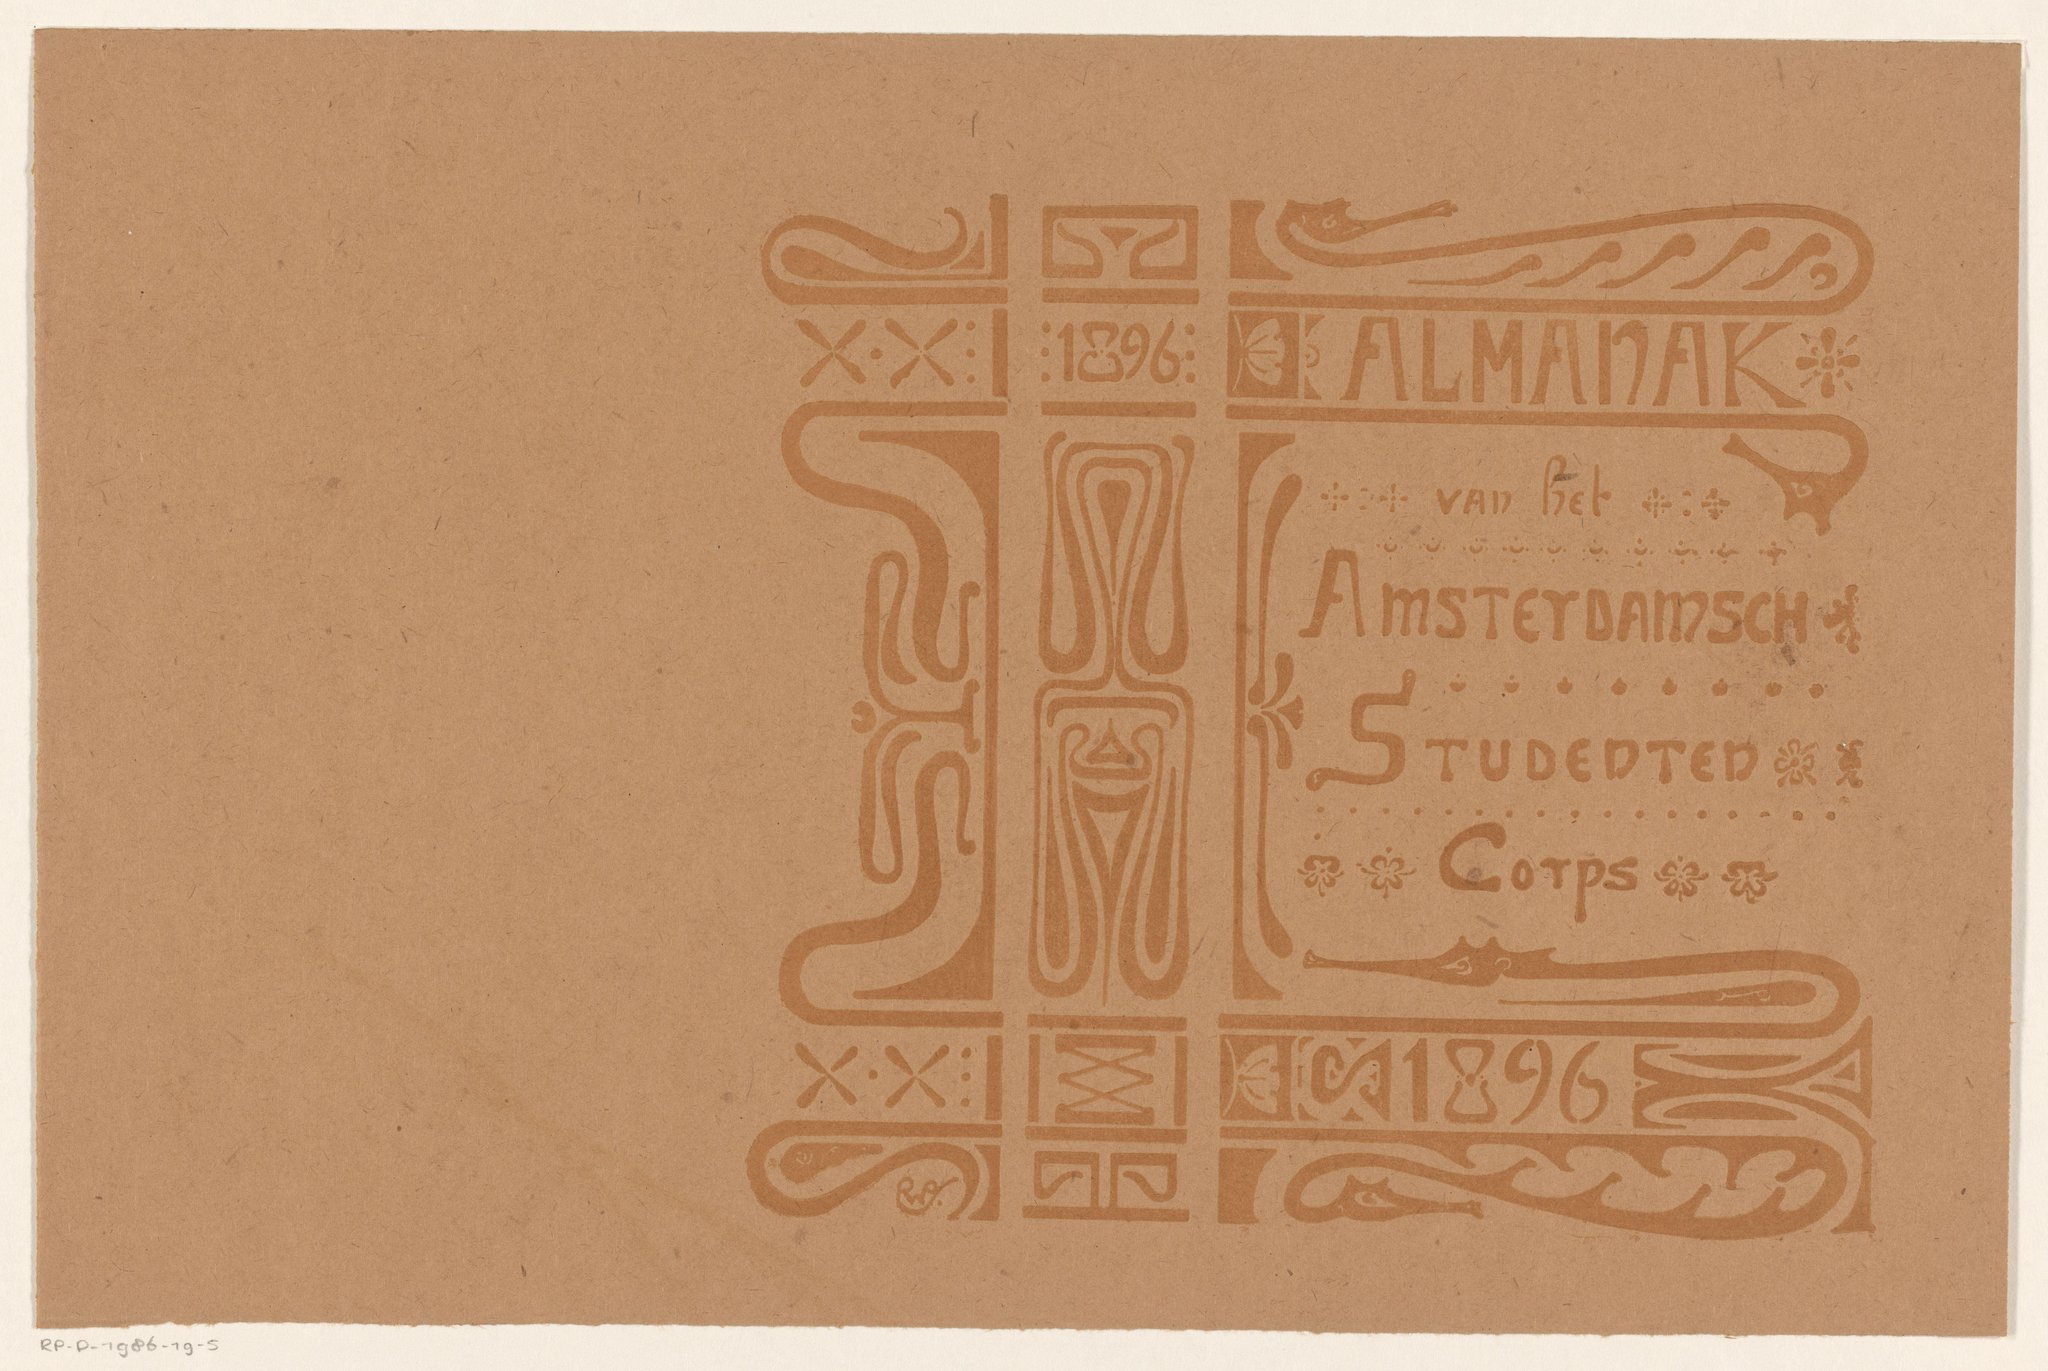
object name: study for binding design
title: Bandontwerp voor: Almanak van het Amsterdamsch Studenten Corps, 1896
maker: reinier willem petrus de vries (1874-1953)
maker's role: draughtsman, print maker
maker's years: 1874-1953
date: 1896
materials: paper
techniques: printing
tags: ornament ~ combination of straight and curved lines, flowers ~ ornament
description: Bandontwerp voor: Almanak van het Amsterdamsch Studenten Corps. 66e jaargang. S.l.s.n., 1896.